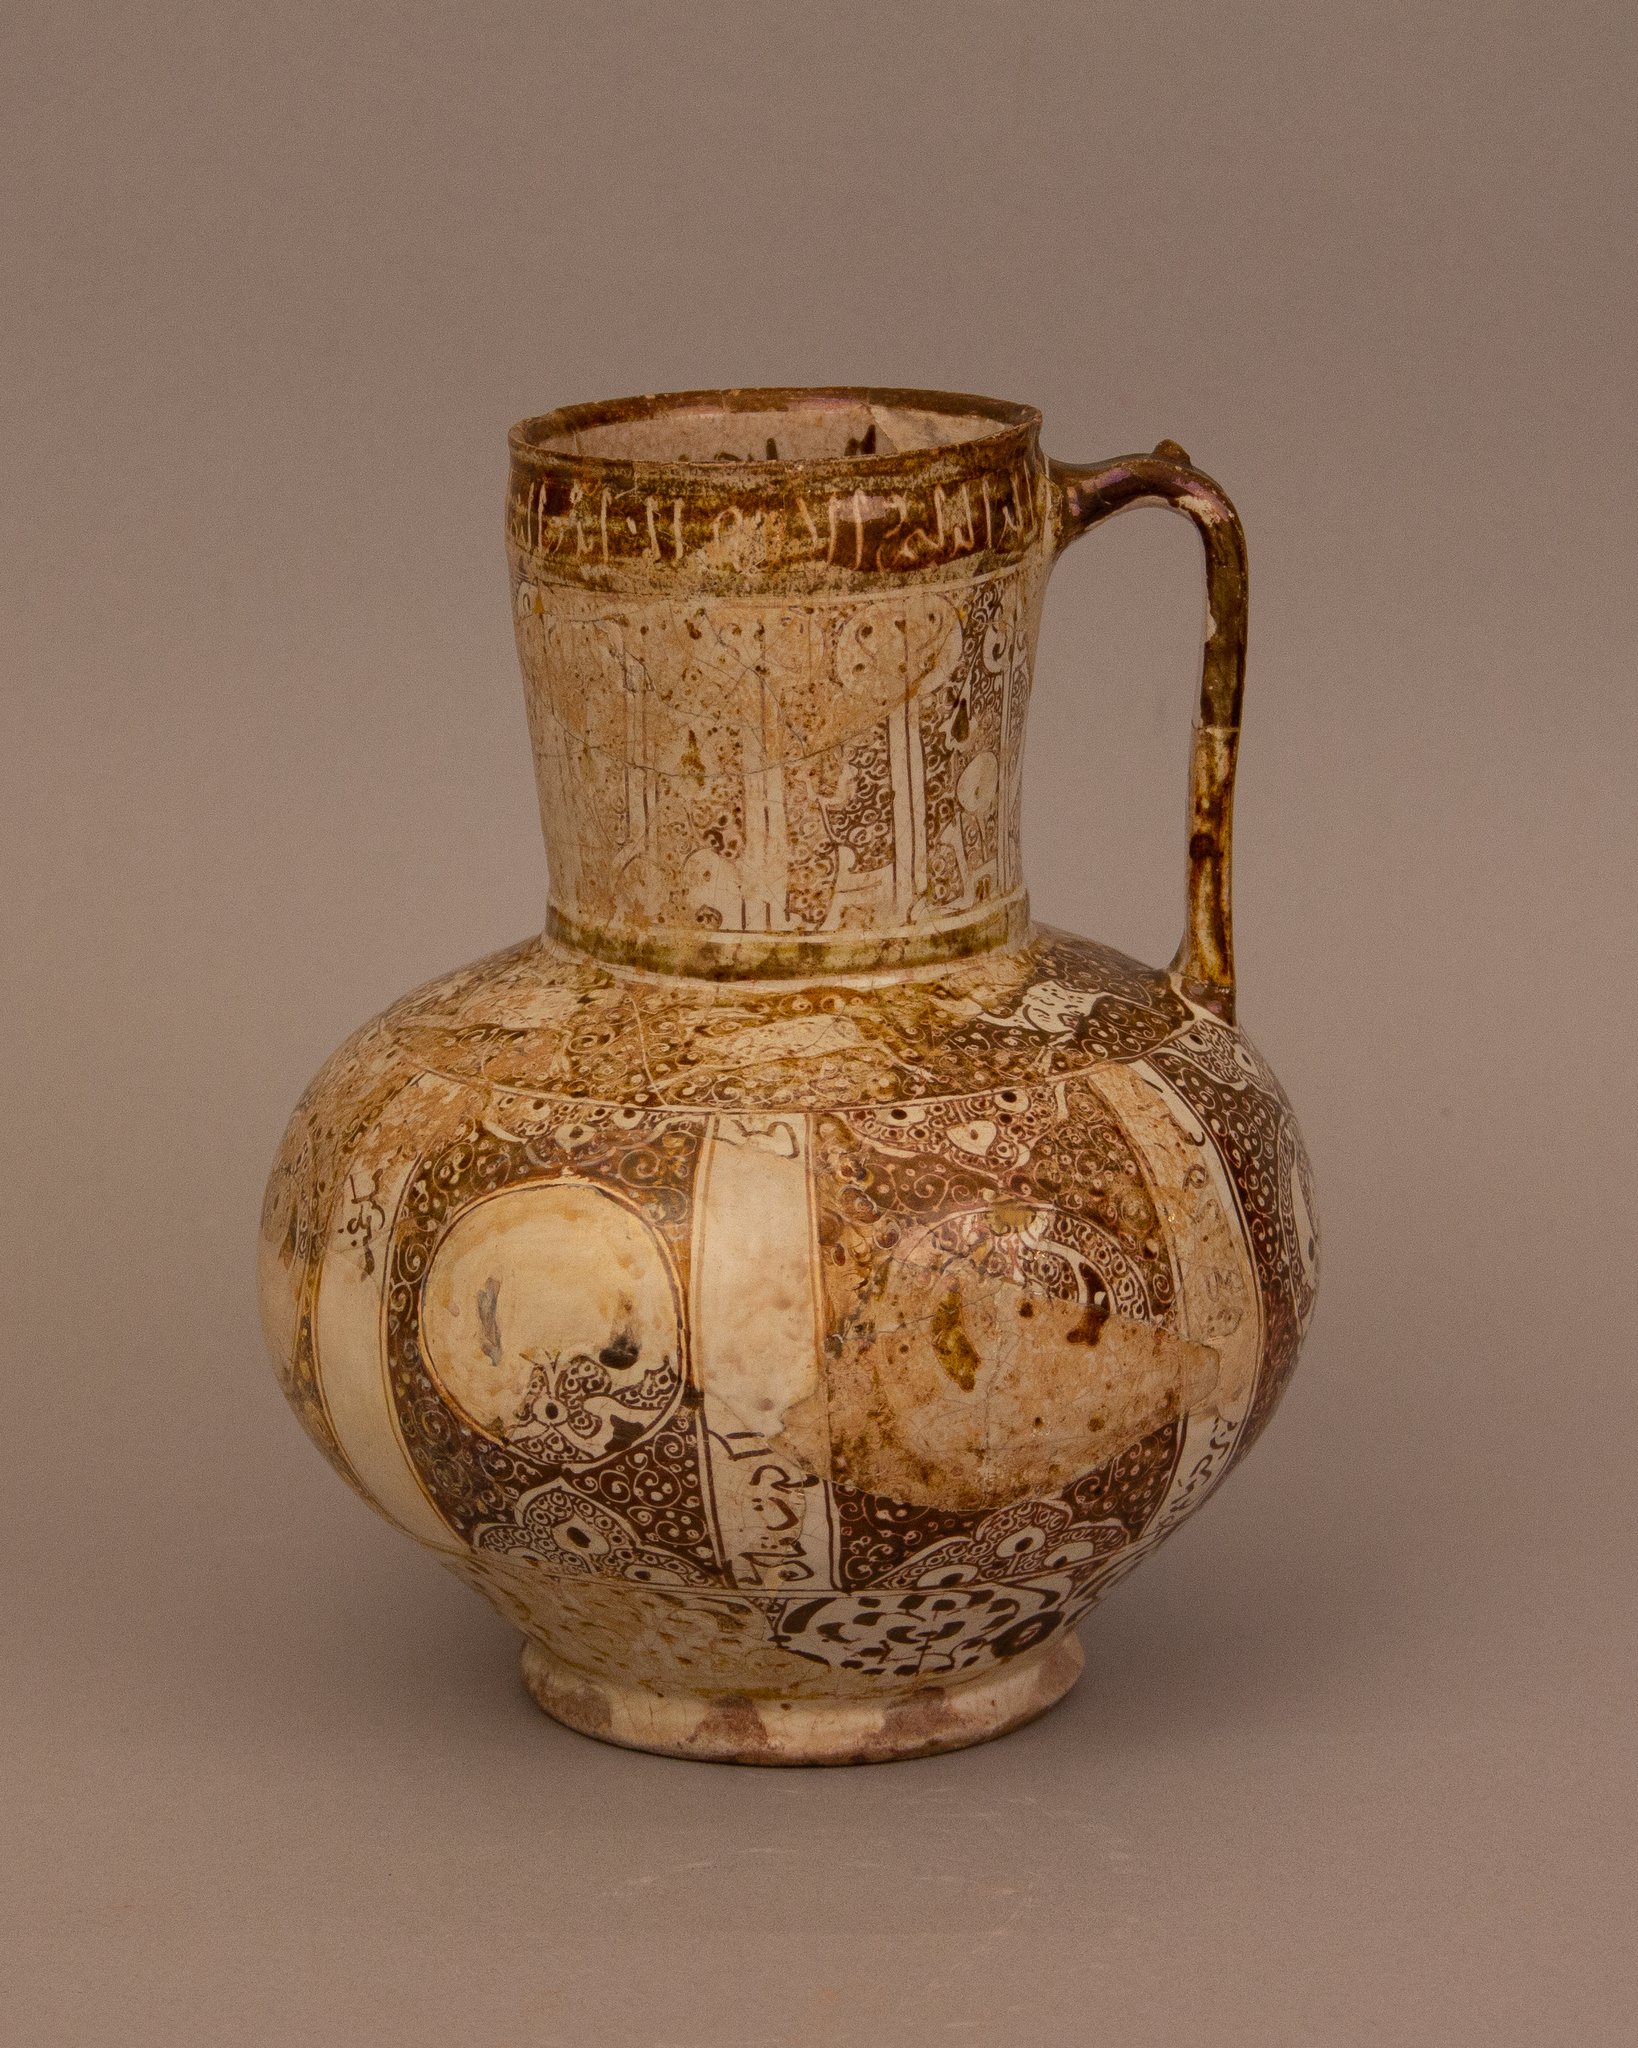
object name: ewer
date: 1201-1300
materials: stonepaste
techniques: glazing, incising, luster painting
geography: iran